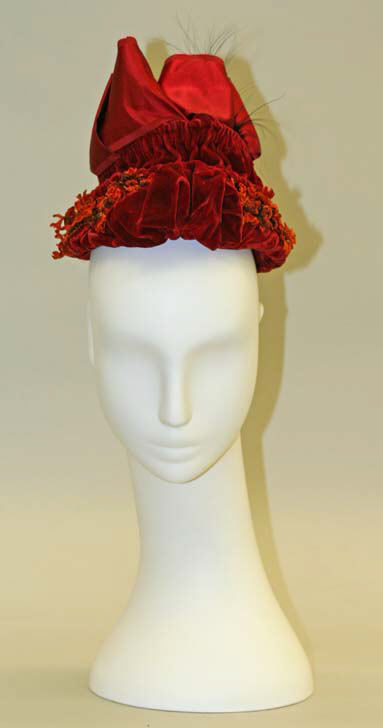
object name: bonnet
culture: french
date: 1880-1889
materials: silk